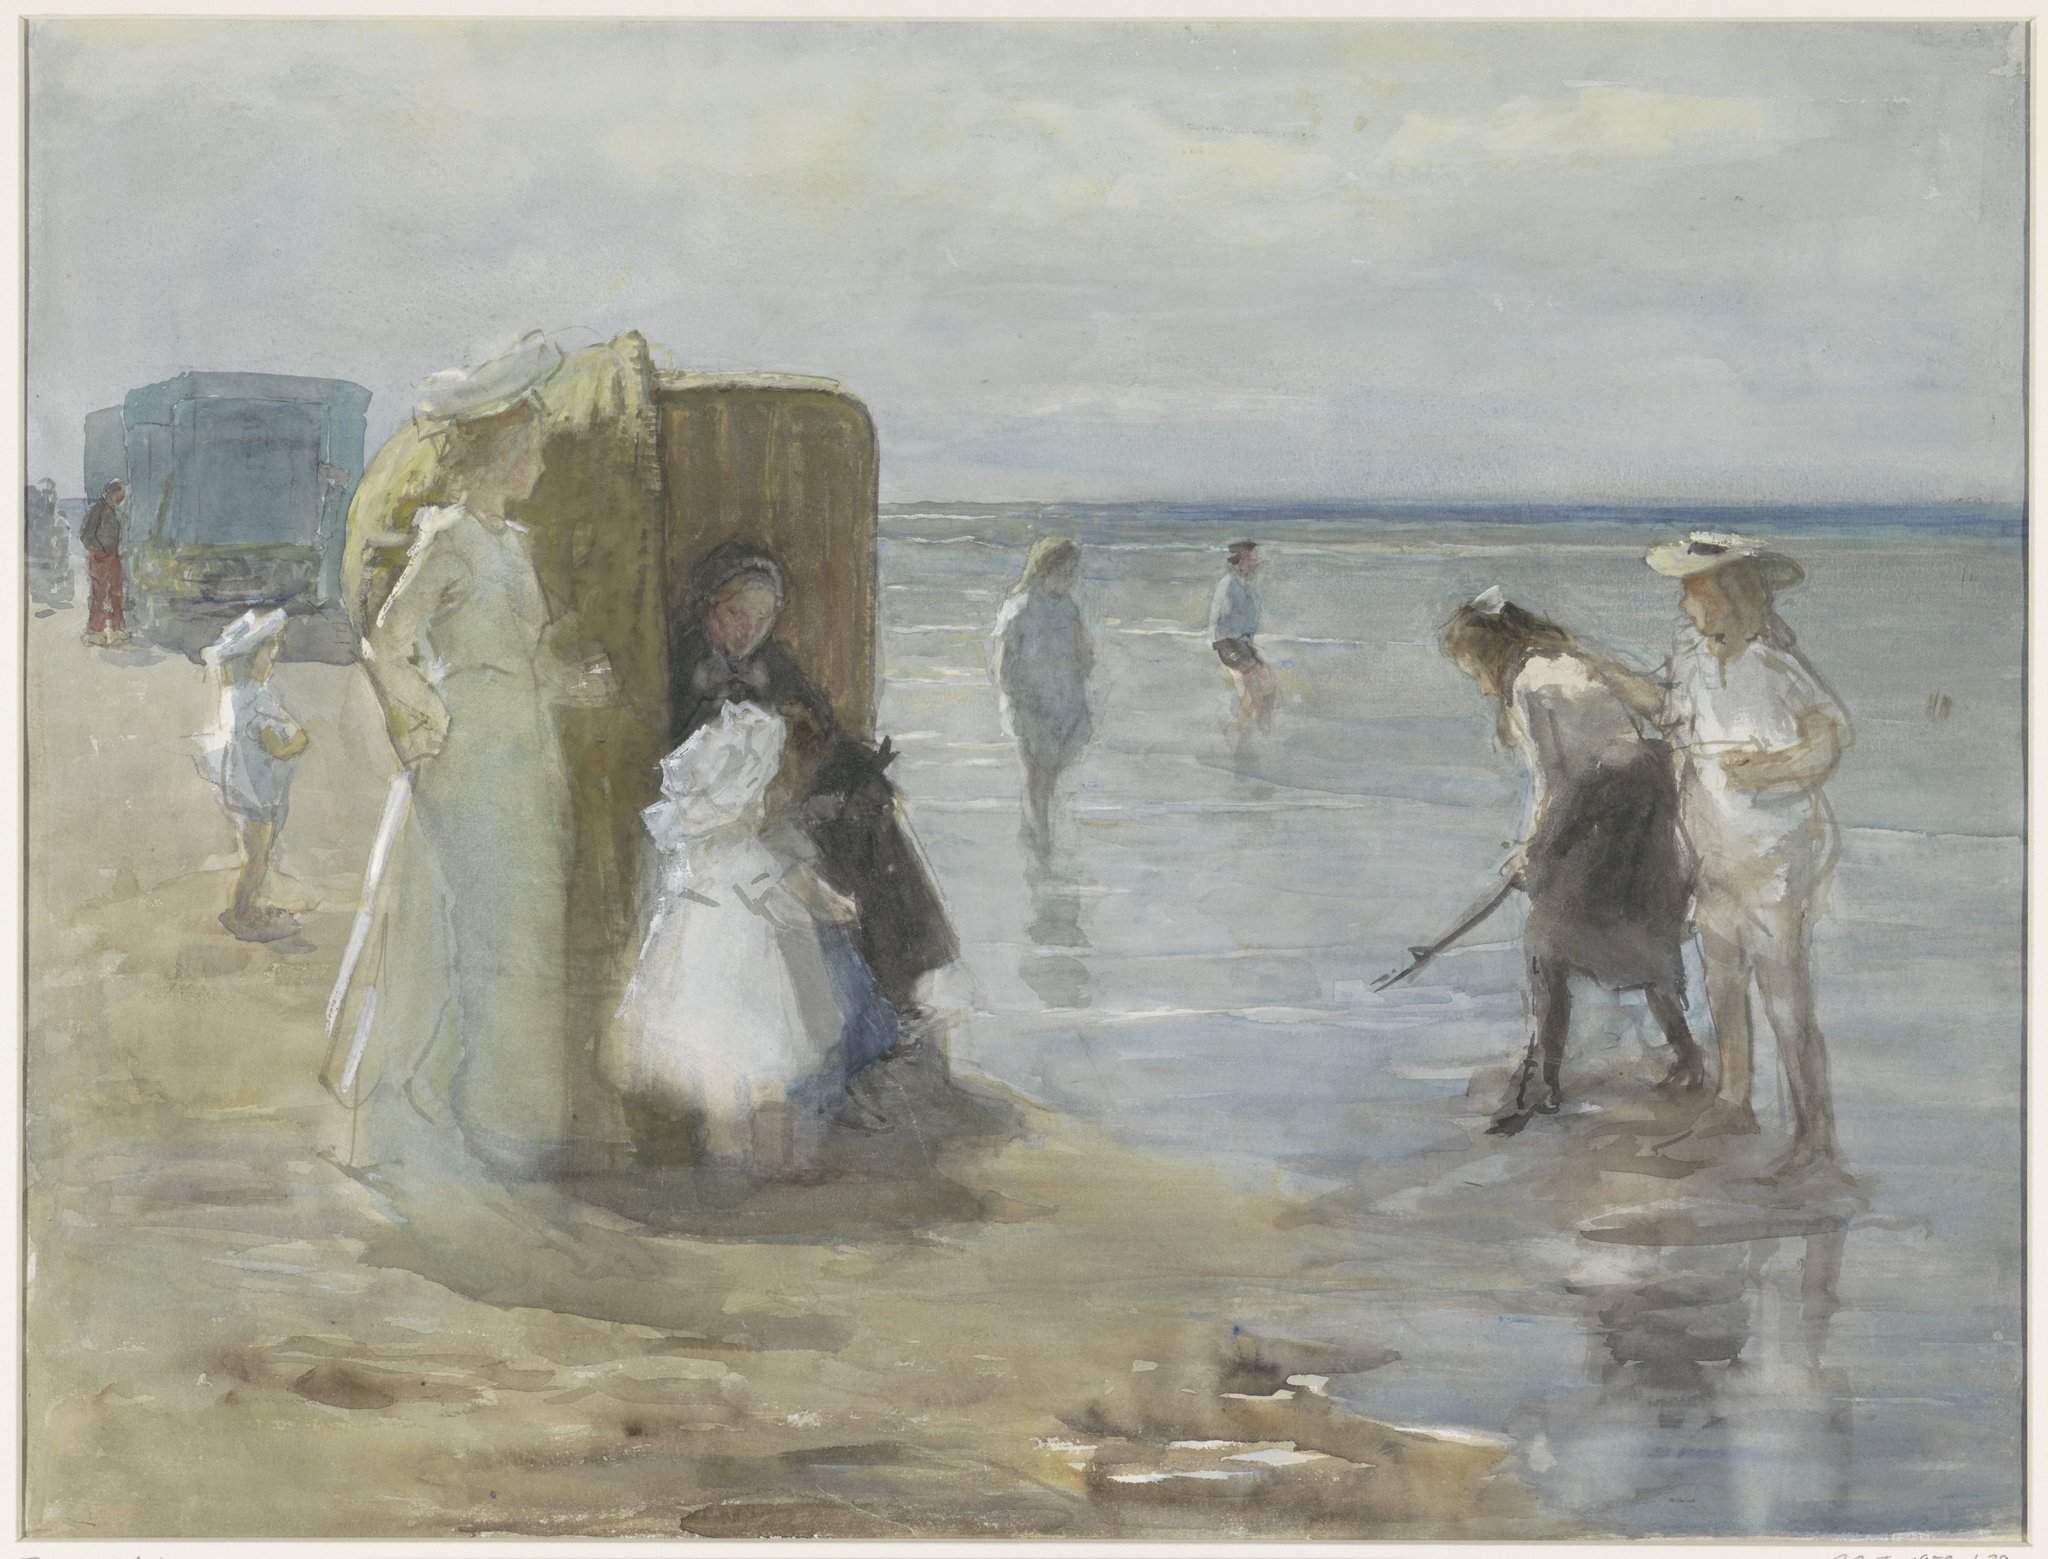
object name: watercolor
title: Gezicht langs de vloedlijn aan het Scheveningse strand, met twee dames en kinderen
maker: johan antonie de jonge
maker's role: draughtsman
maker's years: 1864-1927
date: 1874-1927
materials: chalk, paper, watercolor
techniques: brush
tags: beach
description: Gezicht langs de vloedlijn aan het Scheveningse strand, met twee dames bij een strandstoel en kinderen aan het pootje baden.